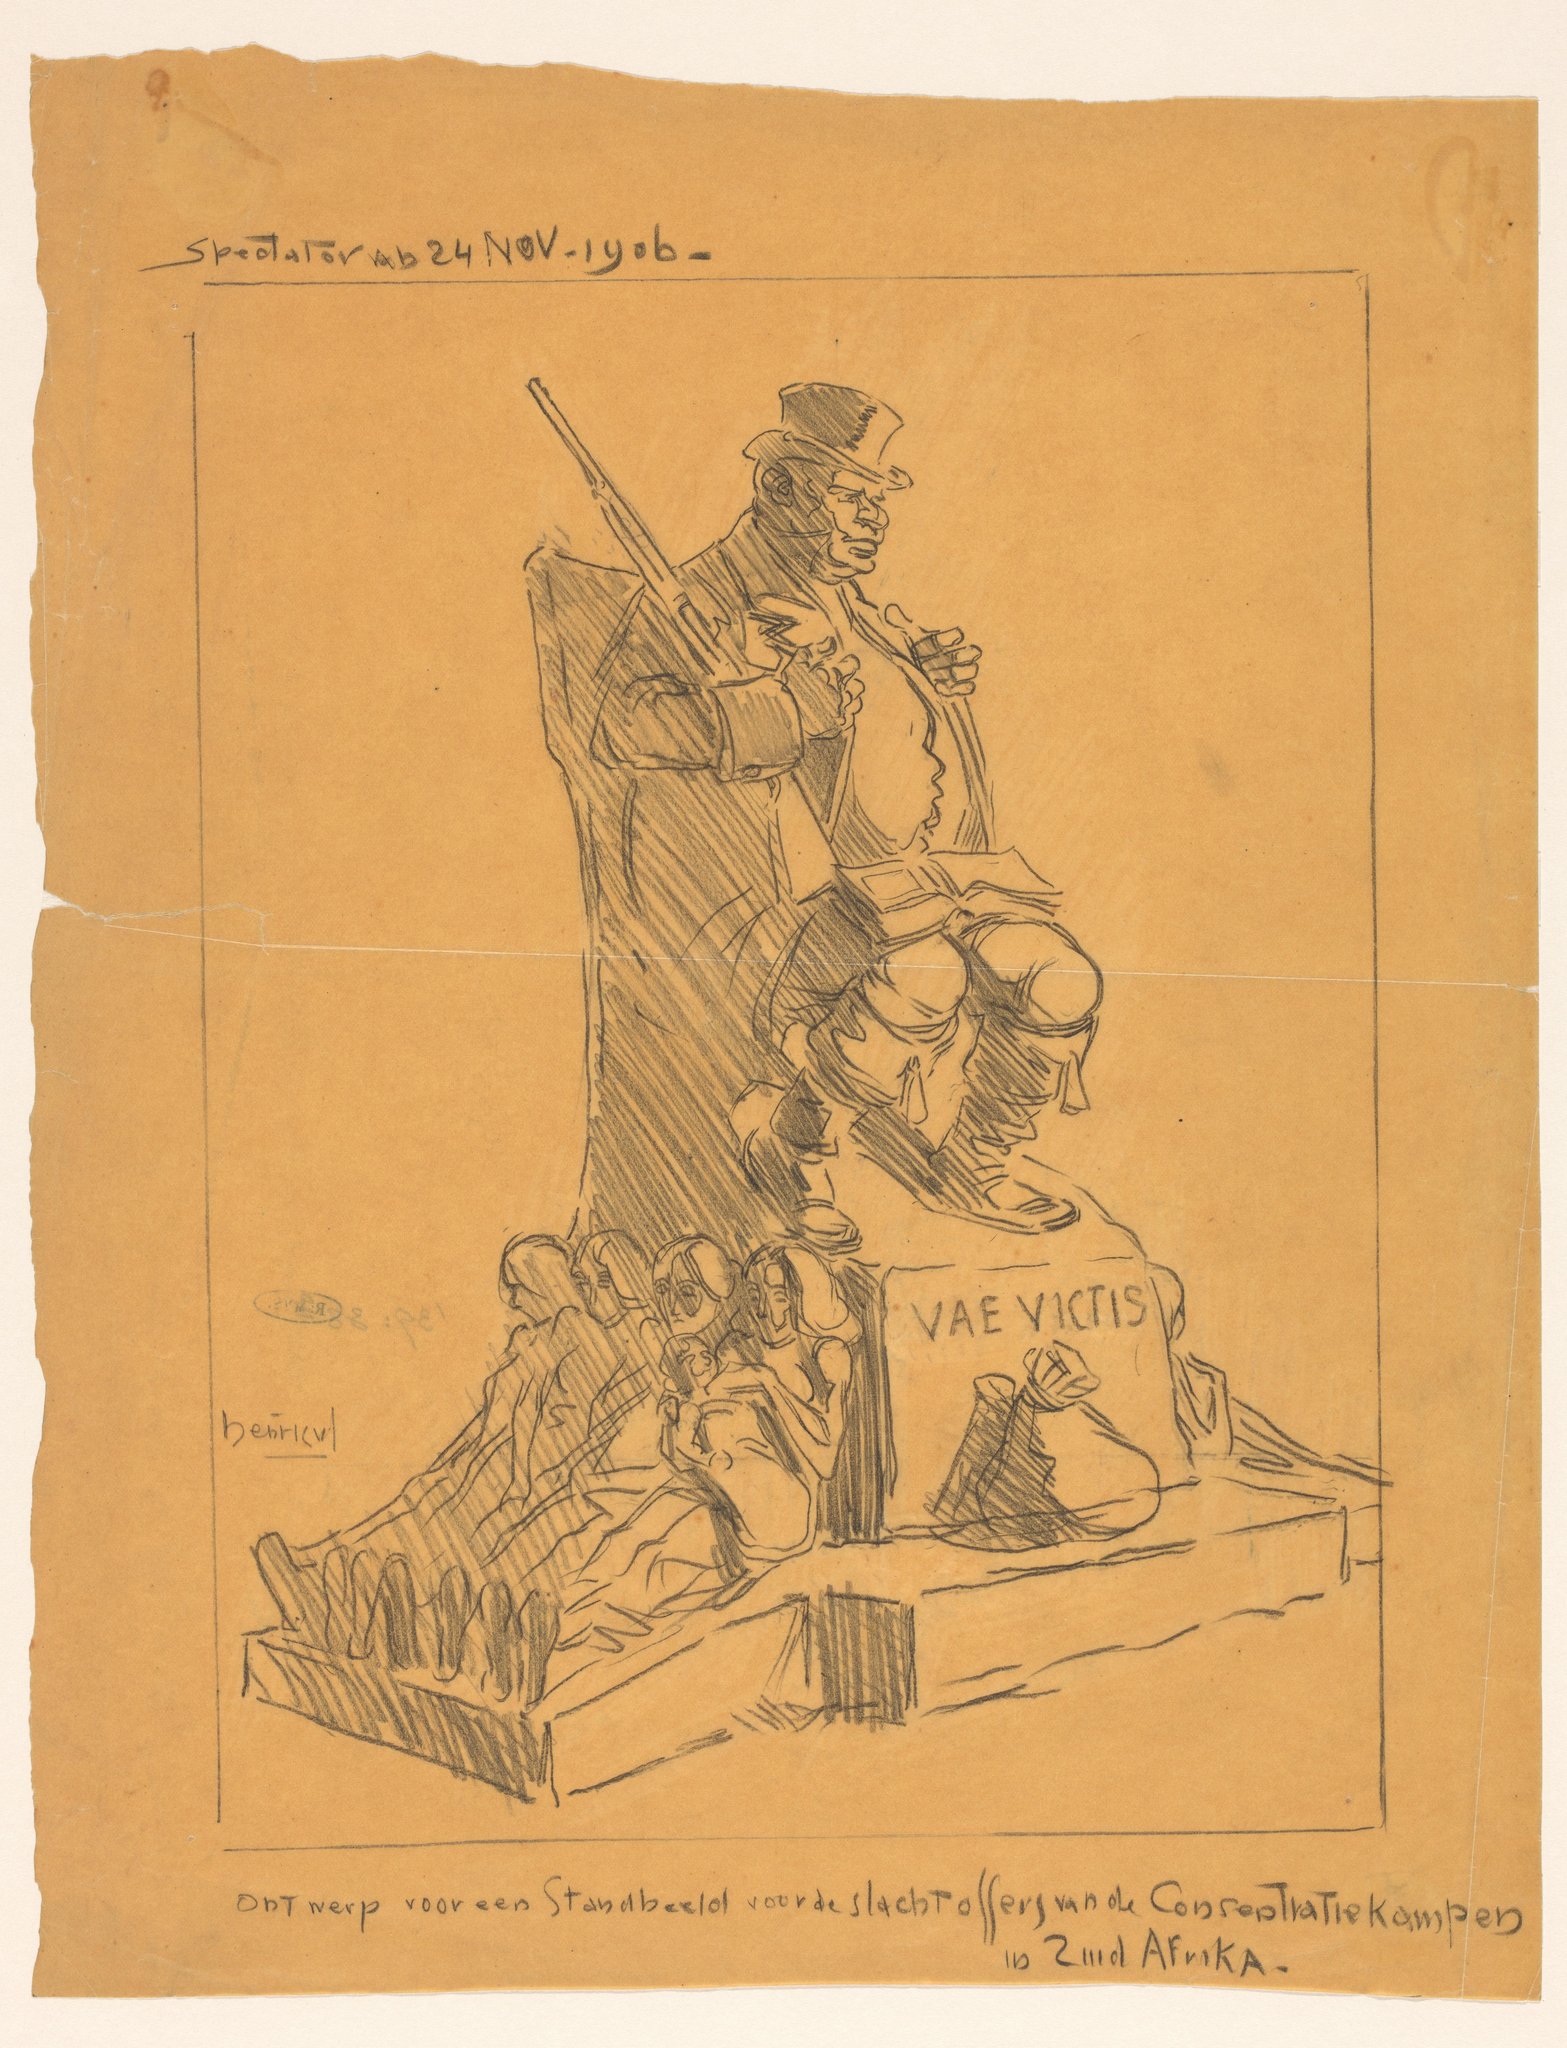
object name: design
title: Ontwerp voor een spotprent met monument voor slachtoffers van concentratiekampen in Zuid-Afrika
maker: henricus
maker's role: draughtsman, print maker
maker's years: 1867-1921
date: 1906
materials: chalk, paper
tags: piece of sculpture, reproduction of a piece of sculpture, political caricatures and satires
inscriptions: collector's mark: Lugt 2228a, inscription: ‘spectator van 24 nov-1906-’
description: Ontwerp voor een spotprent met een standbeeld voor de slachtoffers van de concentratiekampen in Zuid-Afrika.